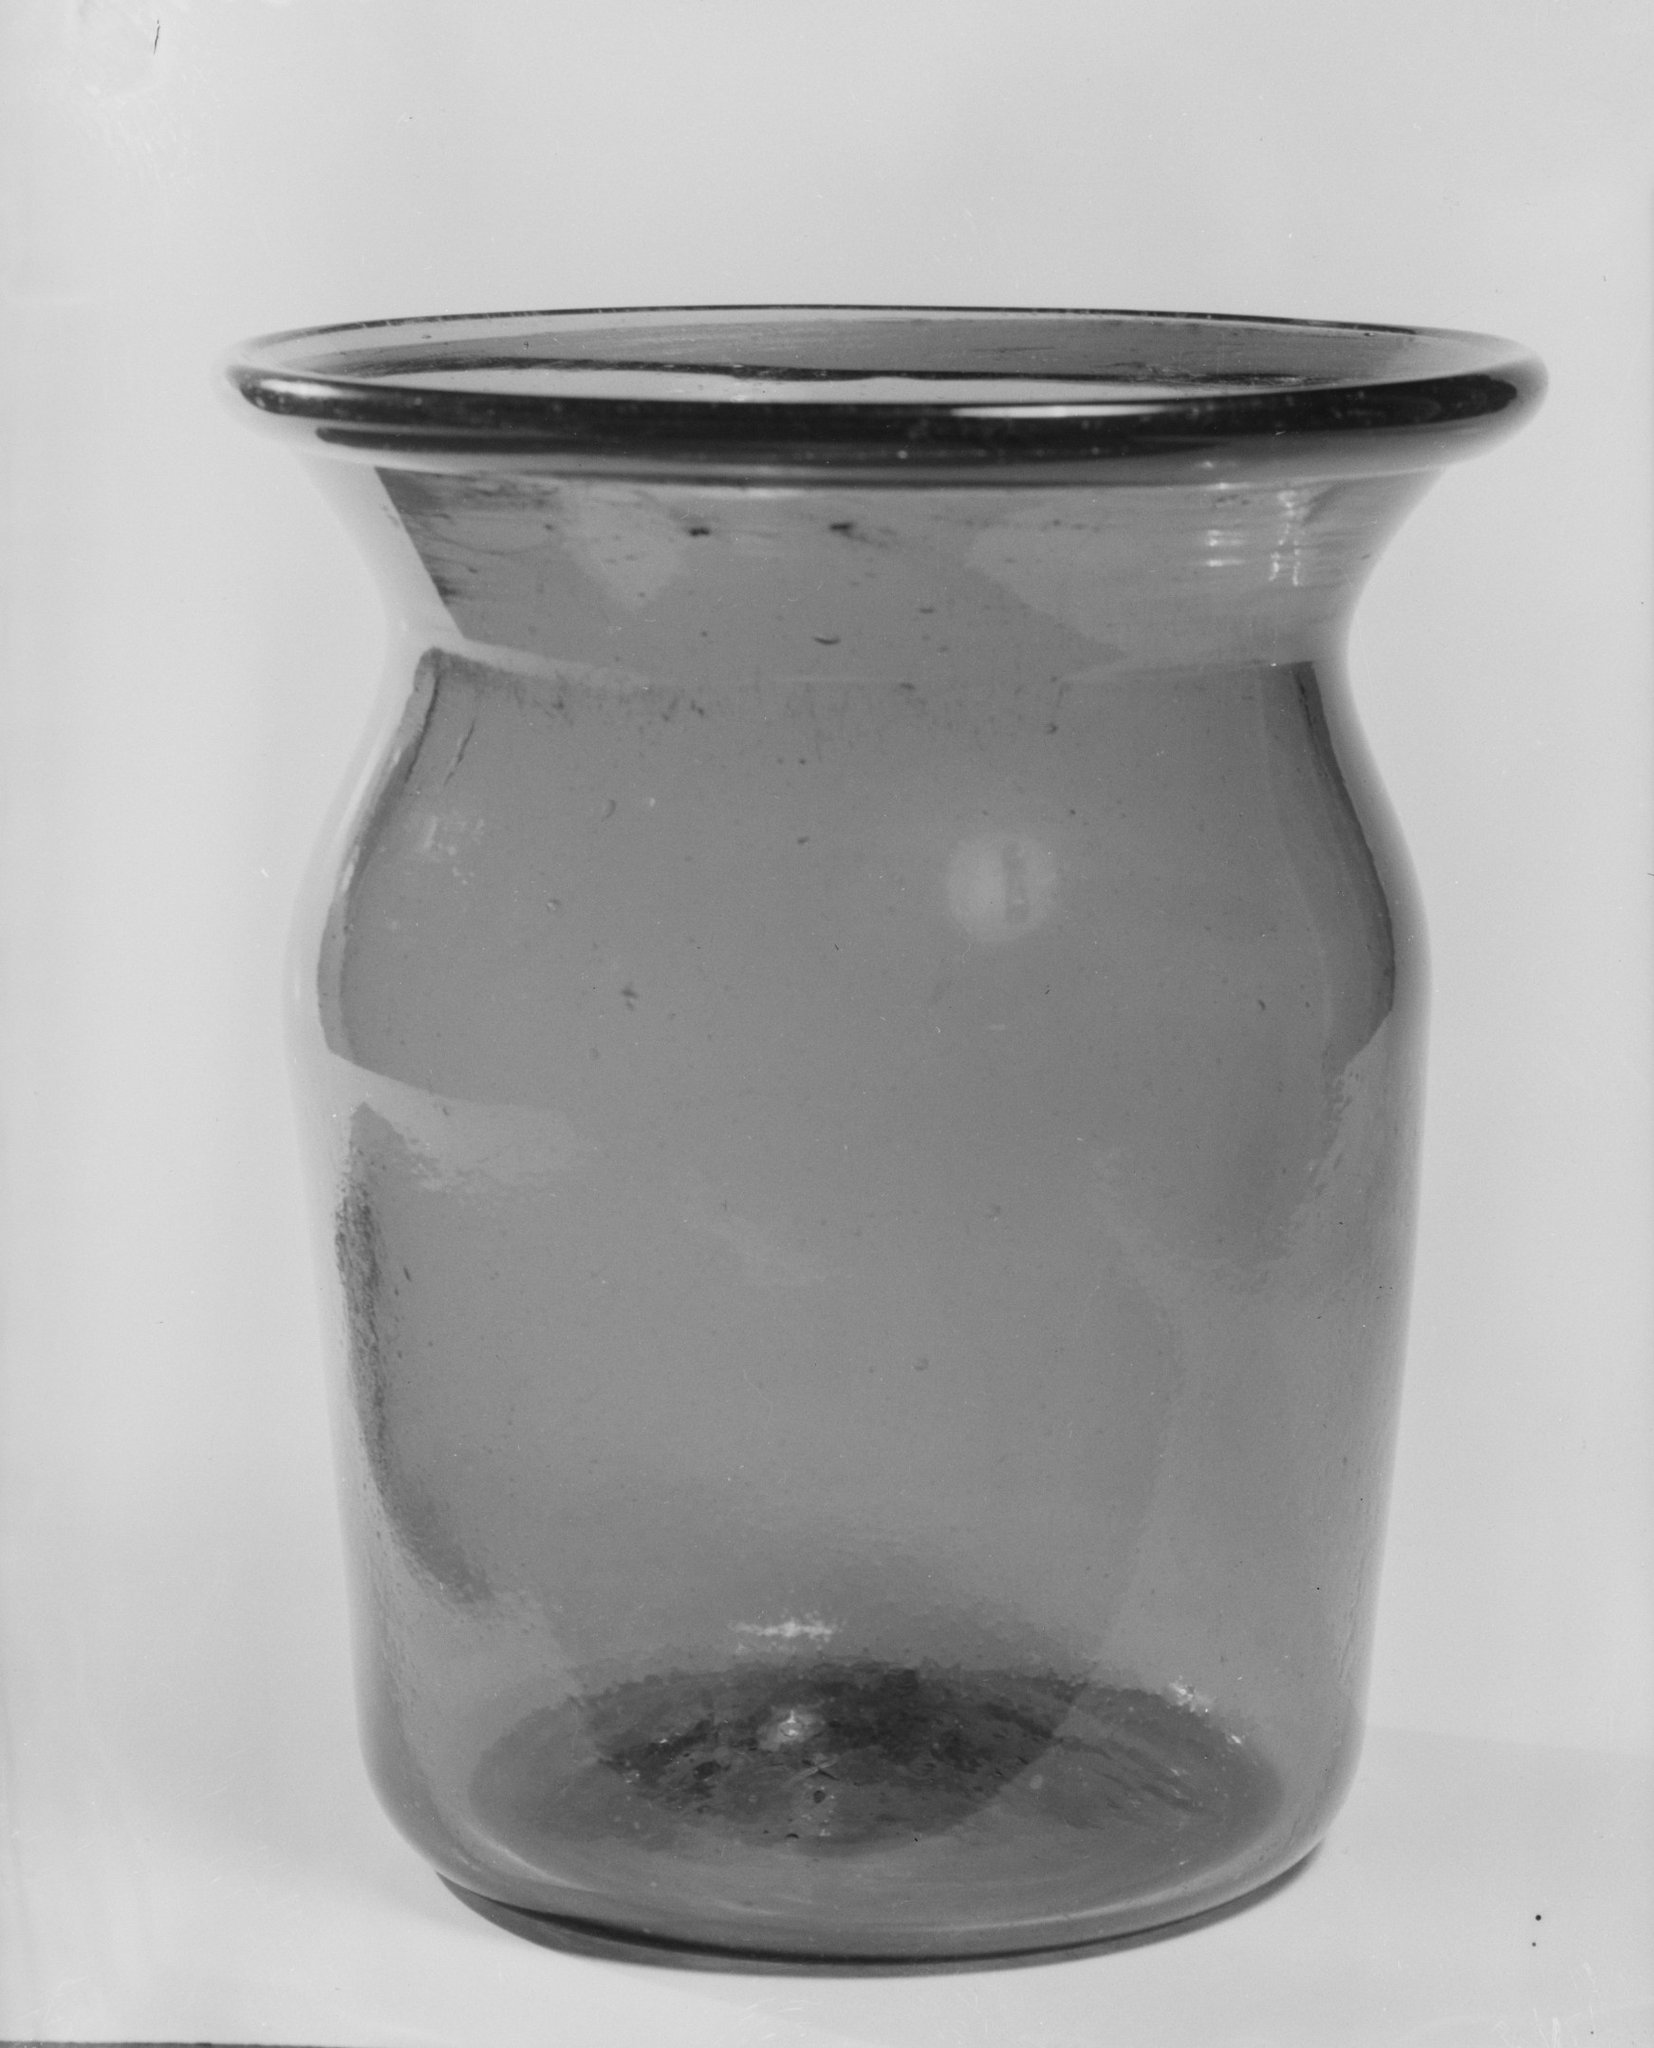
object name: jar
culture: american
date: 1800-1830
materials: amber, glass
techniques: glassblowing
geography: united states